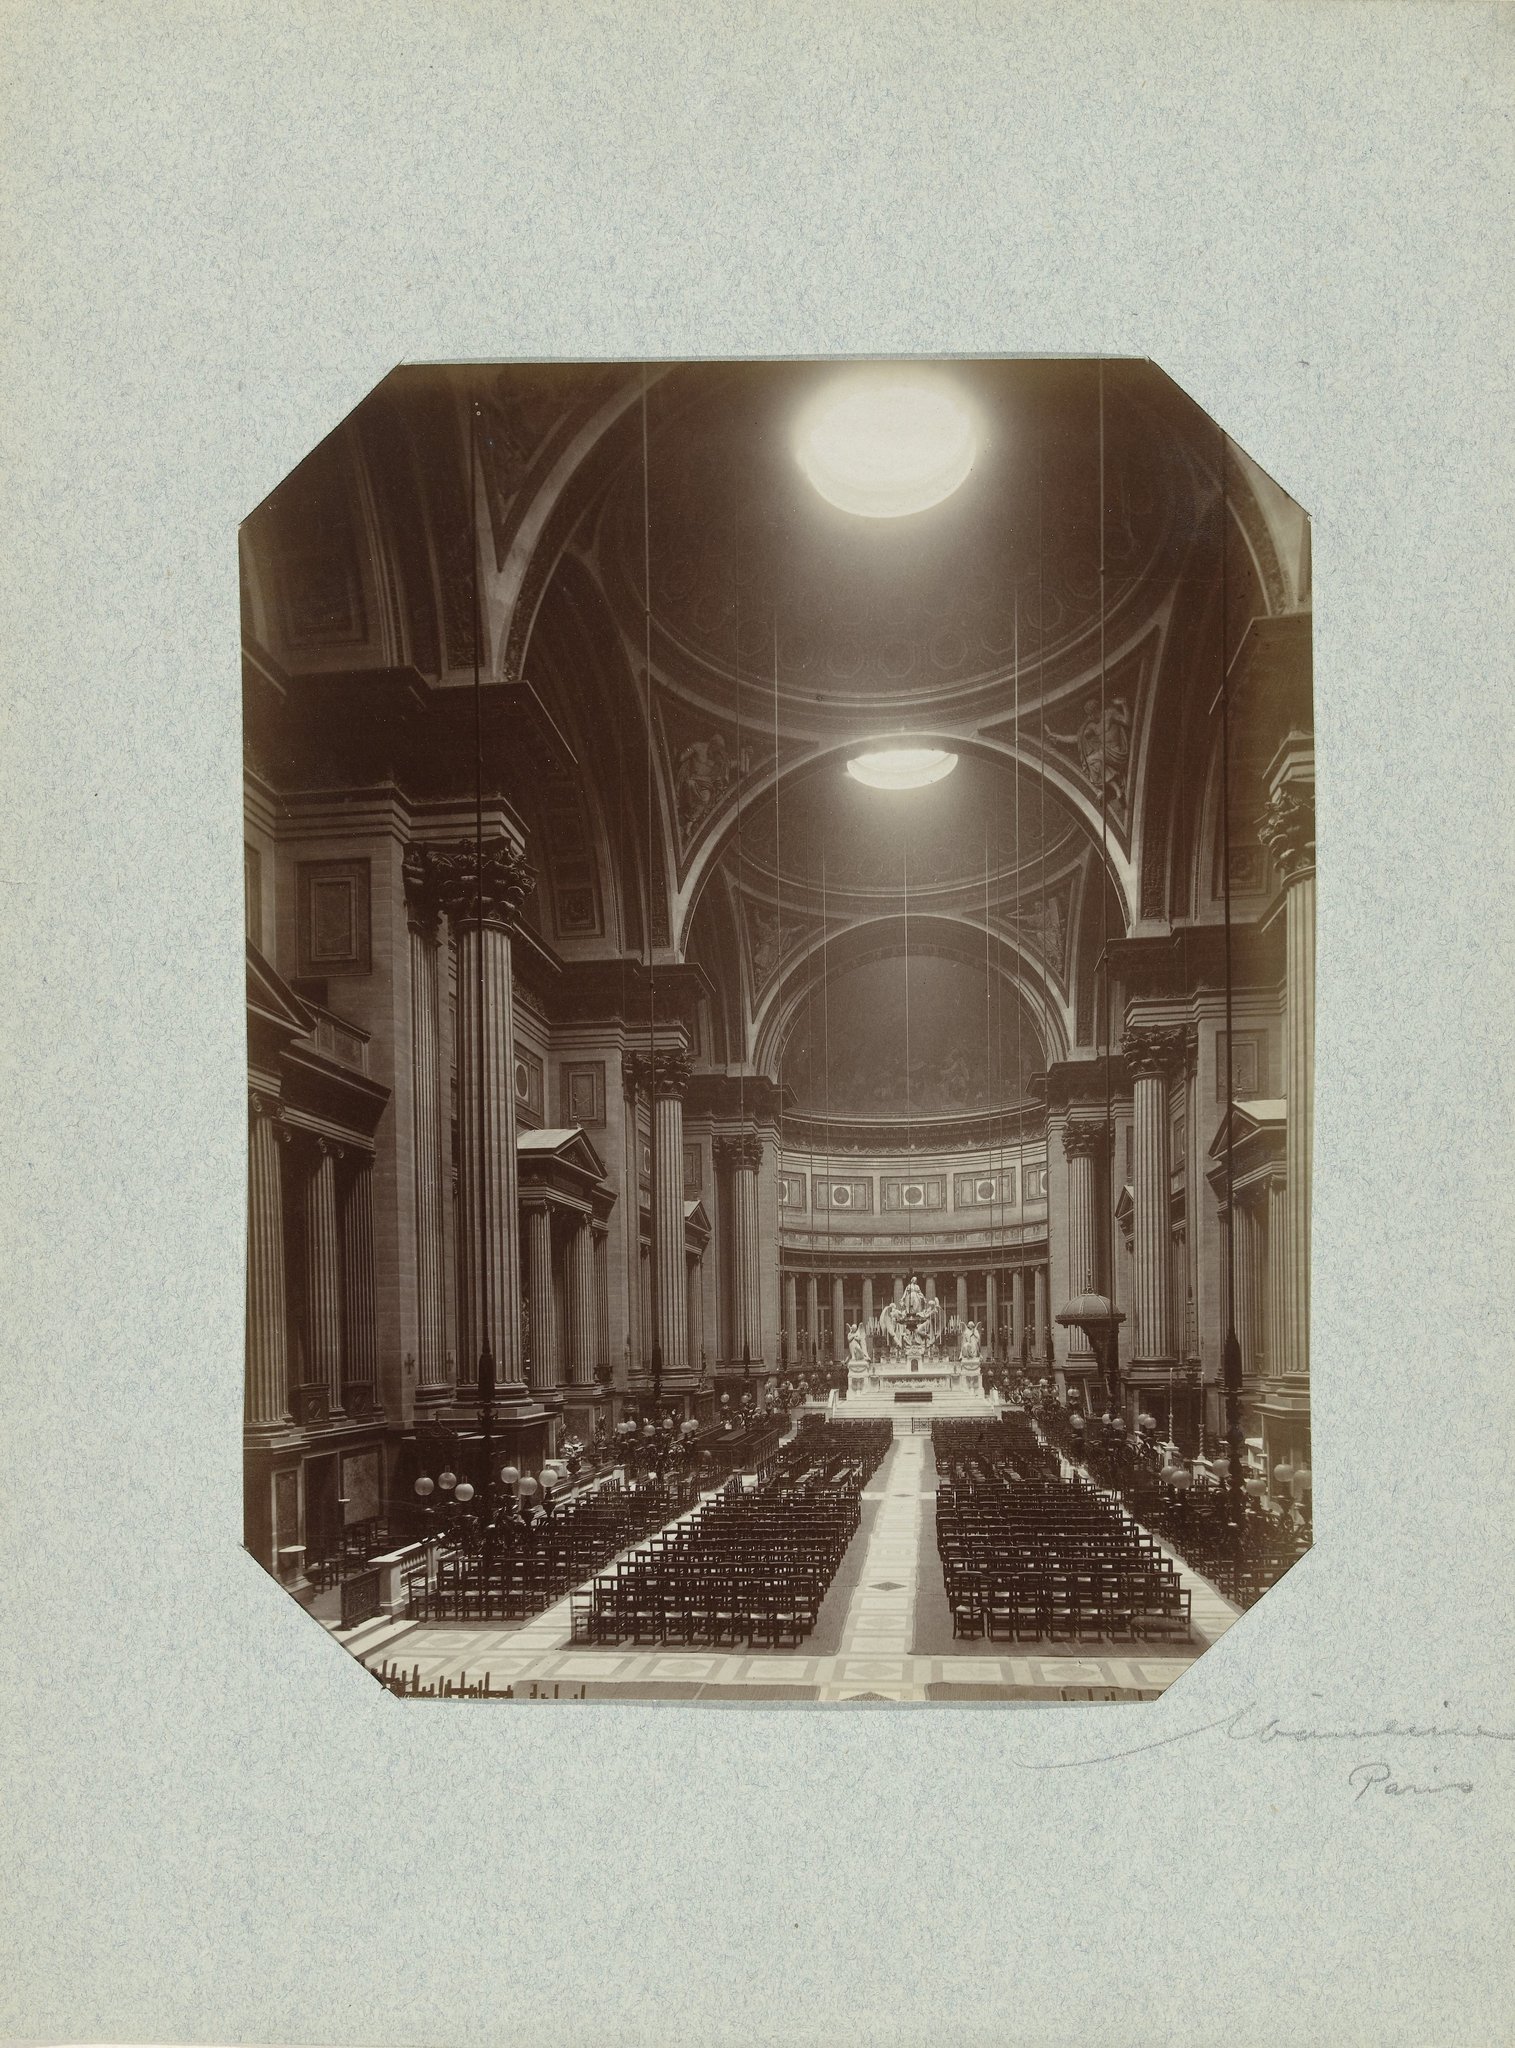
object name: photograph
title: Interieur van La Madeleine in Parijs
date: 1889-1900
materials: cardboard, paper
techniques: albumen print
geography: paris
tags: interior of church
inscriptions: inscription: ‘Madeleine/ Paris’, stamp: ‘14’, stamp: ‘J. RÉSEGOTTI/ EDITEUR/ 8, Rue Vivienne/ PARIS’